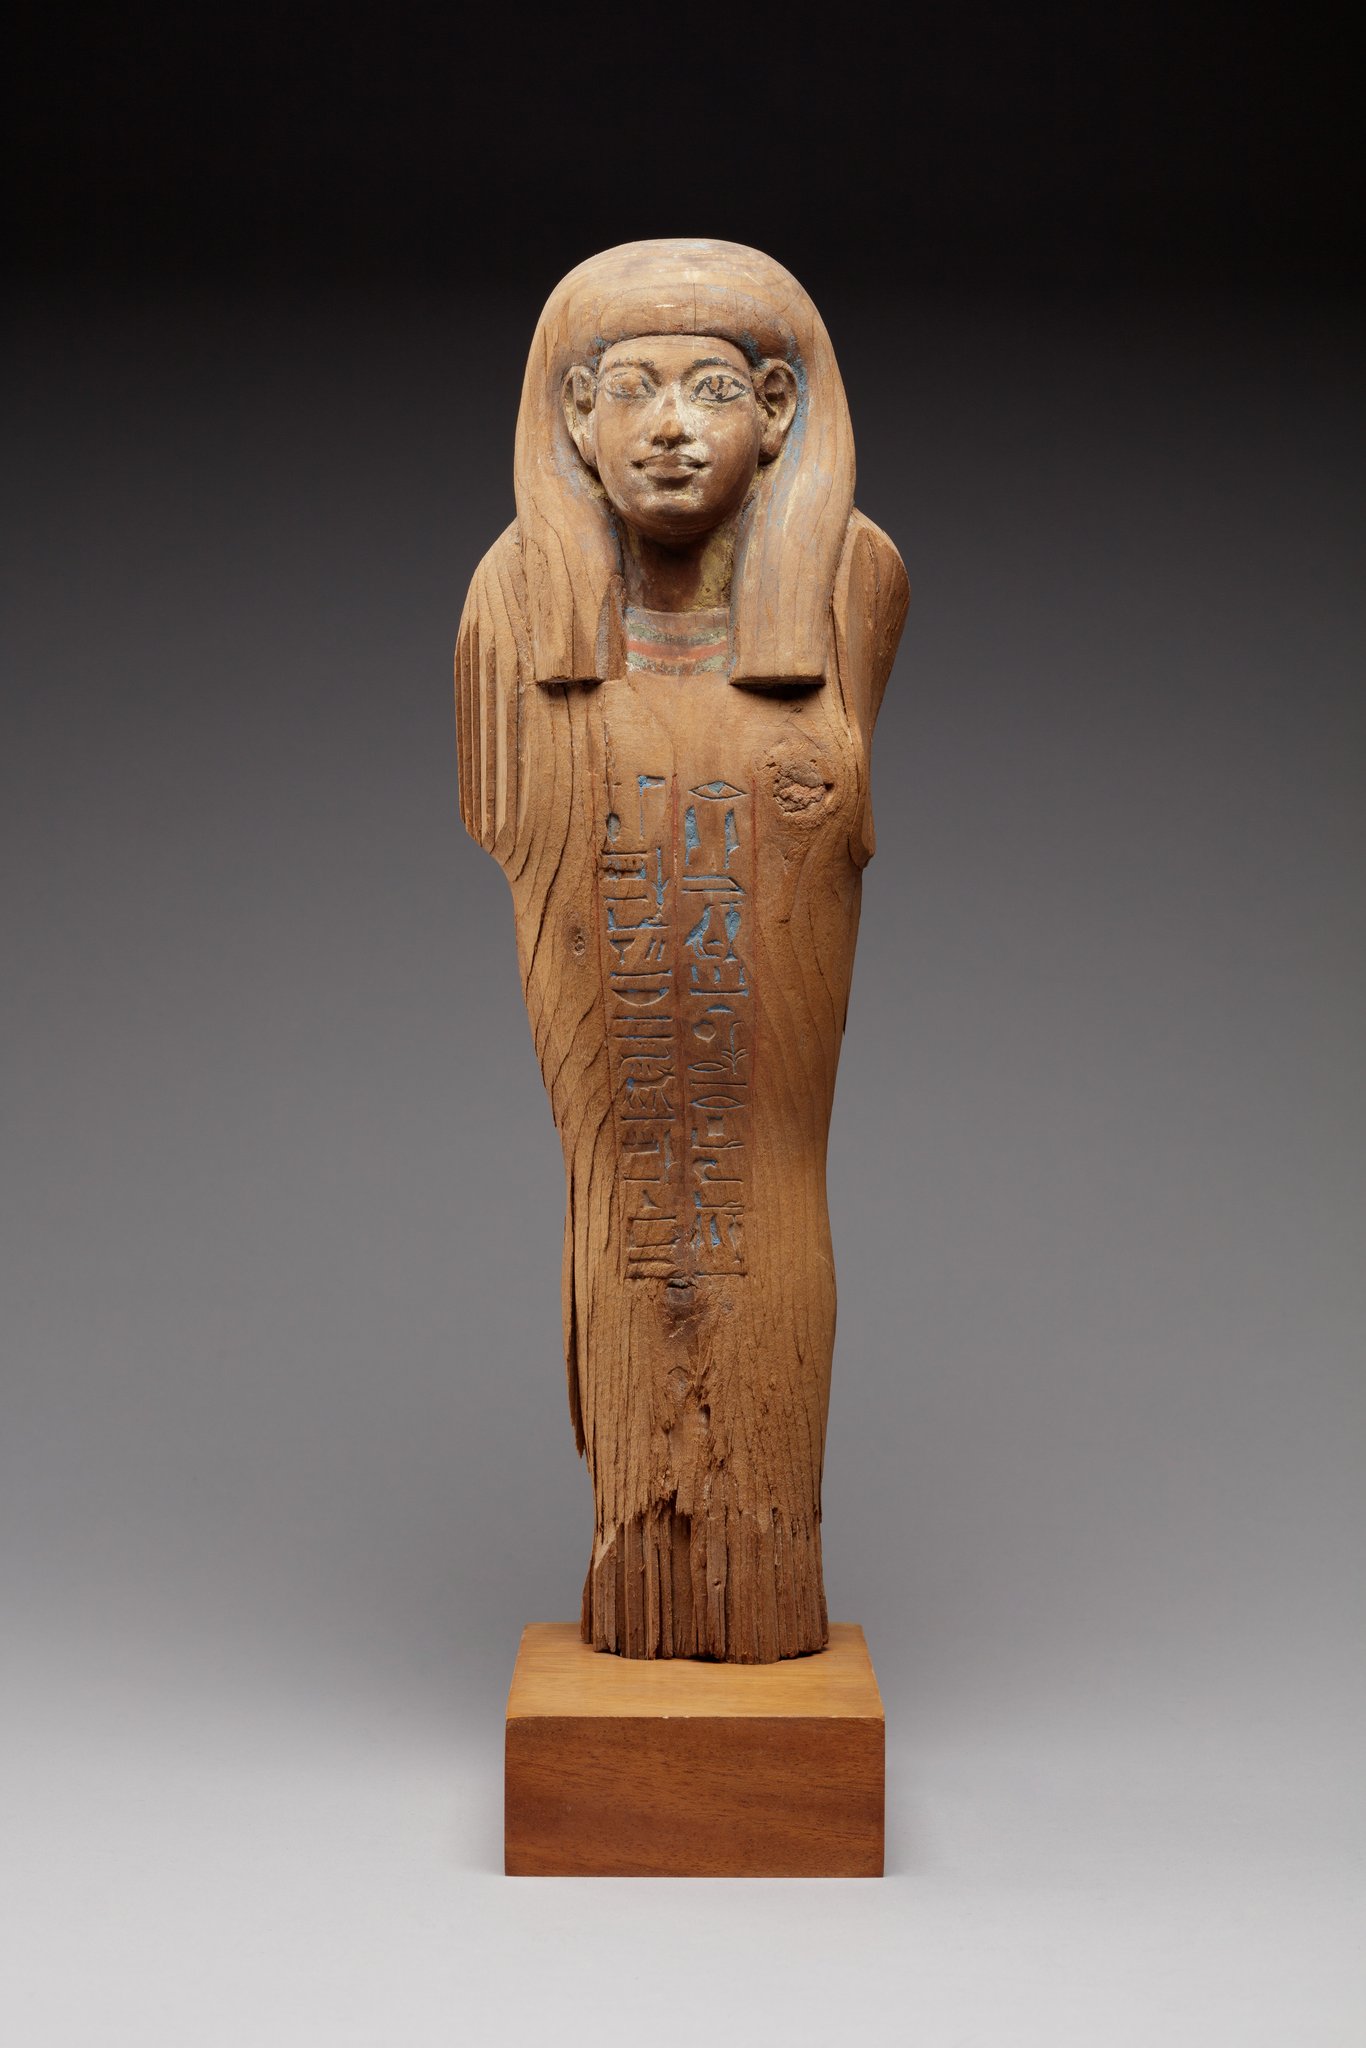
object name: funerary statuette, qenamun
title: Osiride Figure of Kenamun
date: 1427-1400 BCE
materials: paint, wood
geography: memphite region